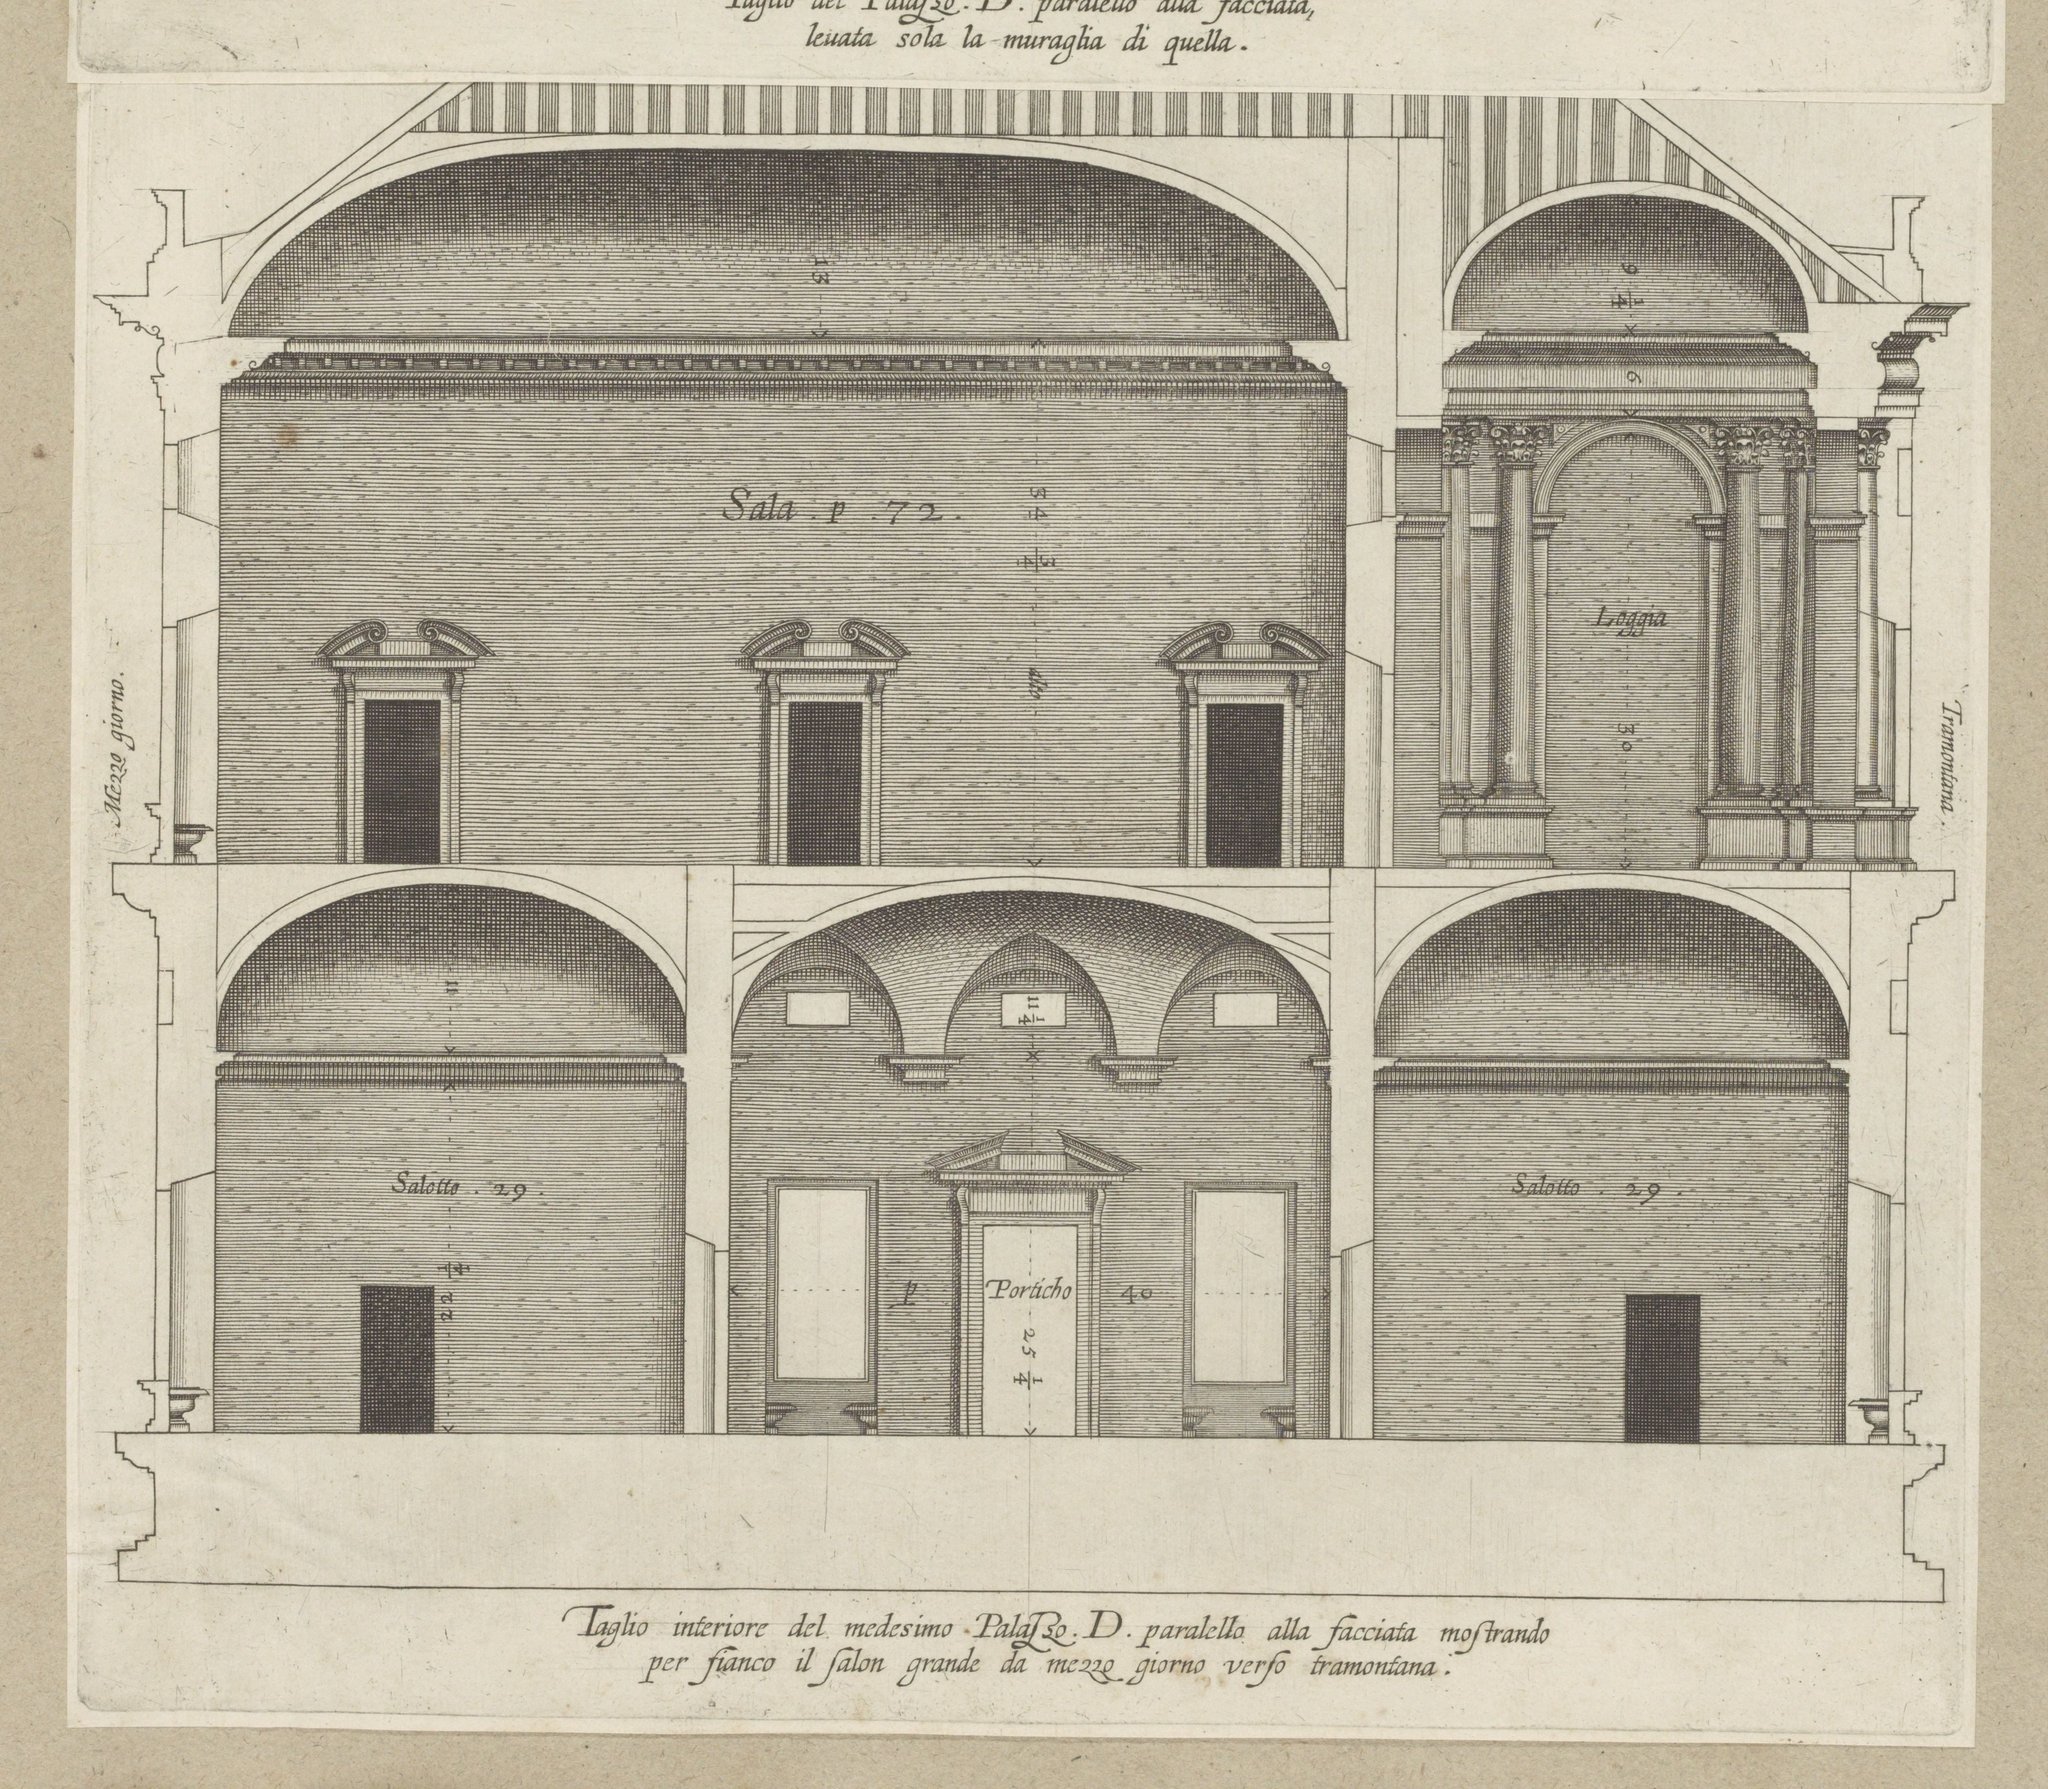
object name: album leaf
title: Taglio interiore del medesimo Palazzo. D. paralello alla facciata mostrando / per fianco il salon grande da mezzo giorno verso tramontana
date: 1622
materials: paper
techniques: engraving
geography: antwerp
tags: hôtel, i.e. small palace in city - aa - civic architecture: inside, section ~ architectural design or model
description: Deze prent maakt deel uit van een album.